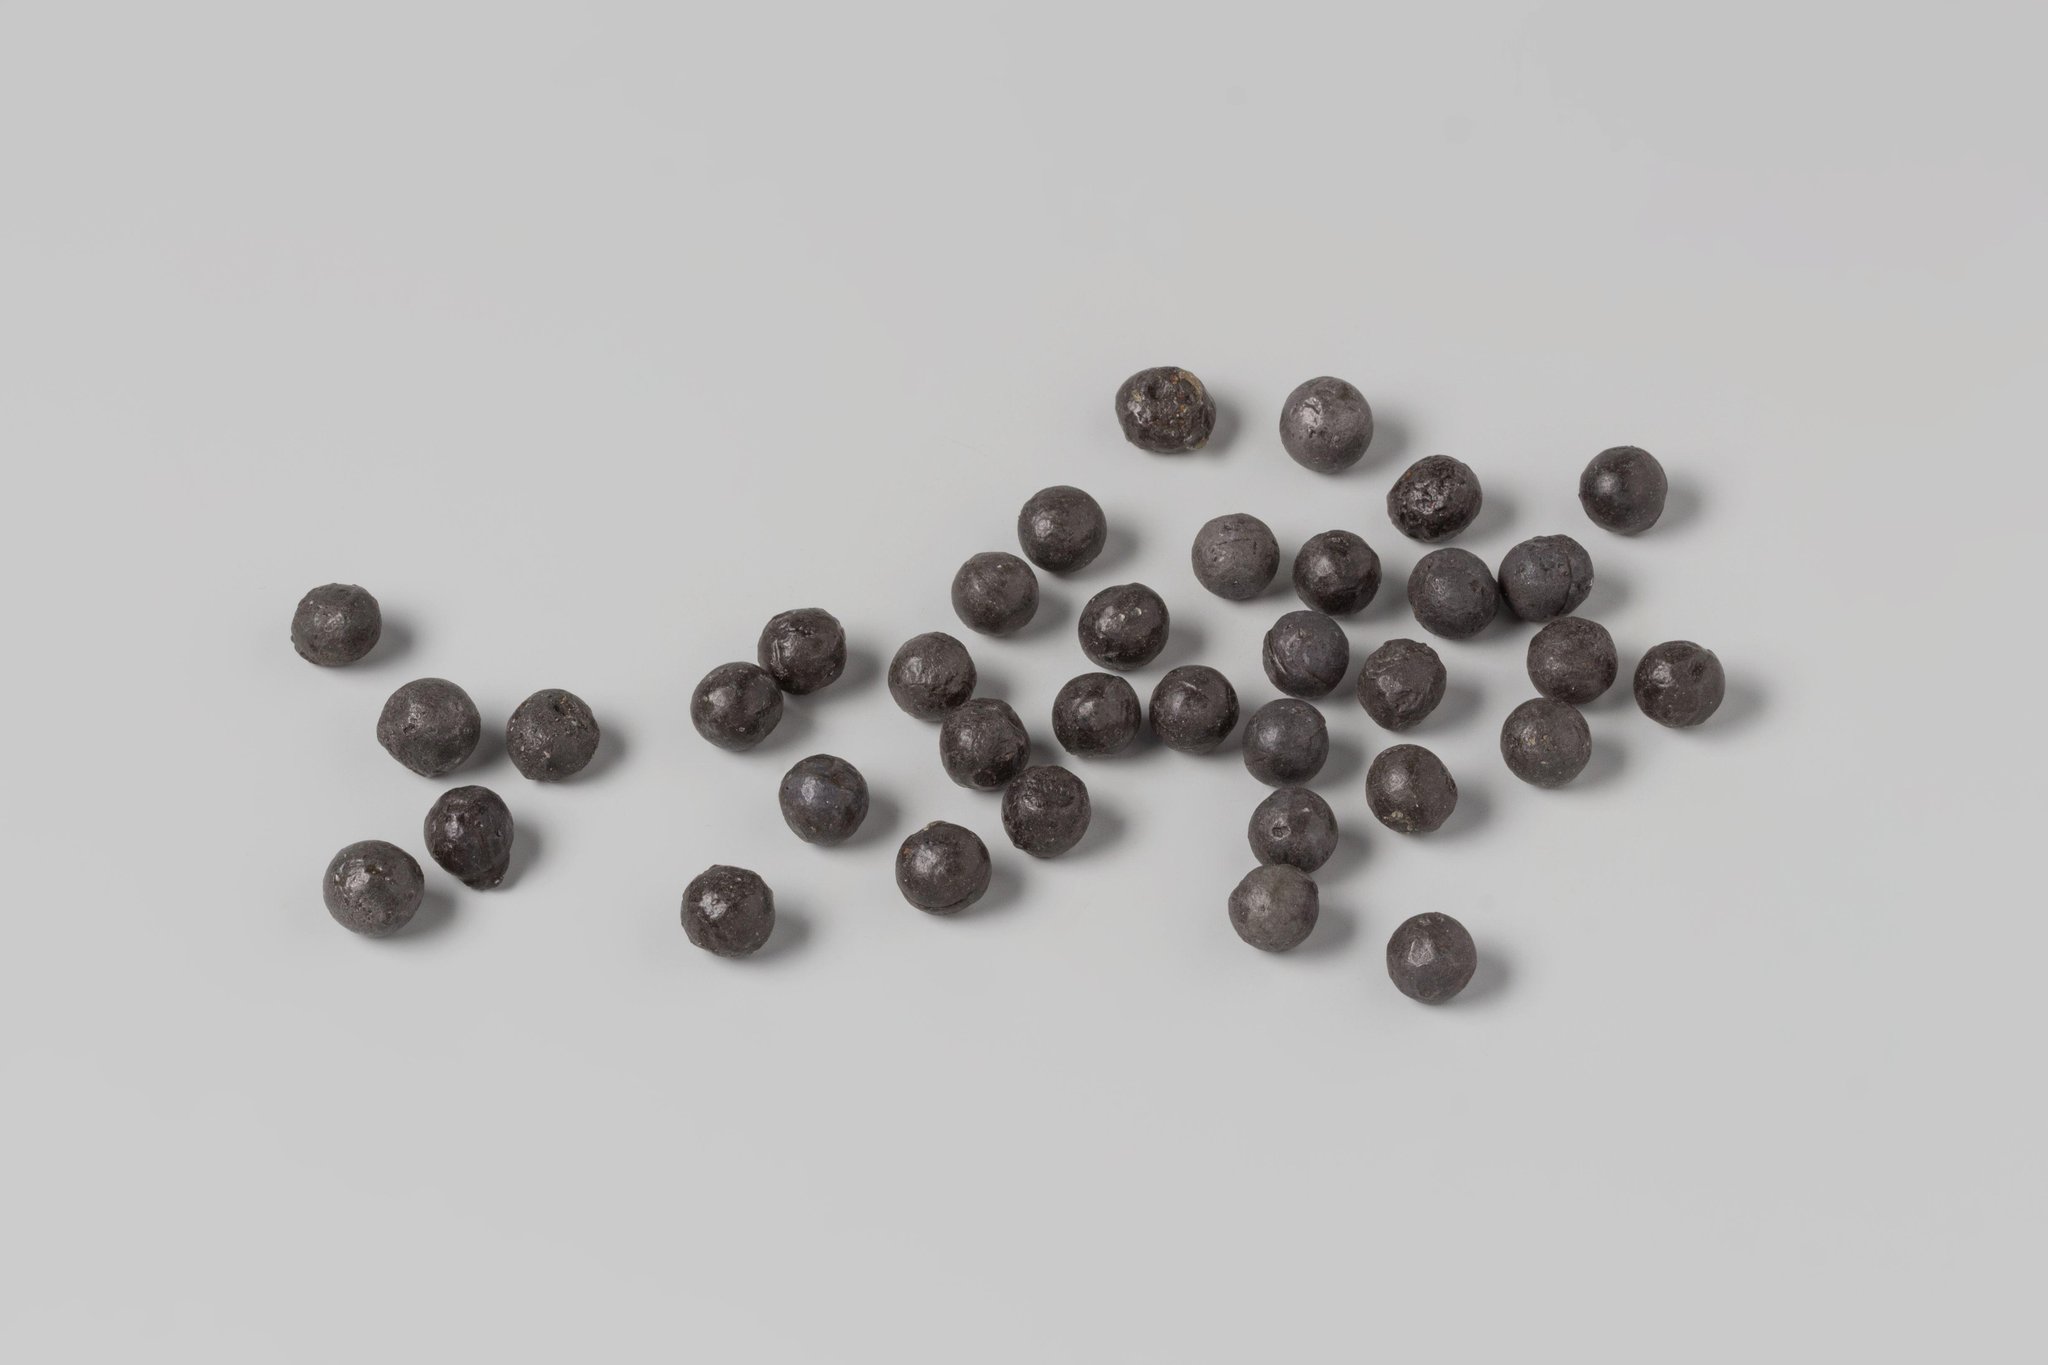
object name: bullet ammunition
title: Pistoolkogels uit het wrak van de Oost-Indiëvaarder Hollandia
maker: Anonymous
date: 1700-1743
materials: lead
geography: netherlands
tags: verenigde oostindische compagnie, hollandia (schip), annet